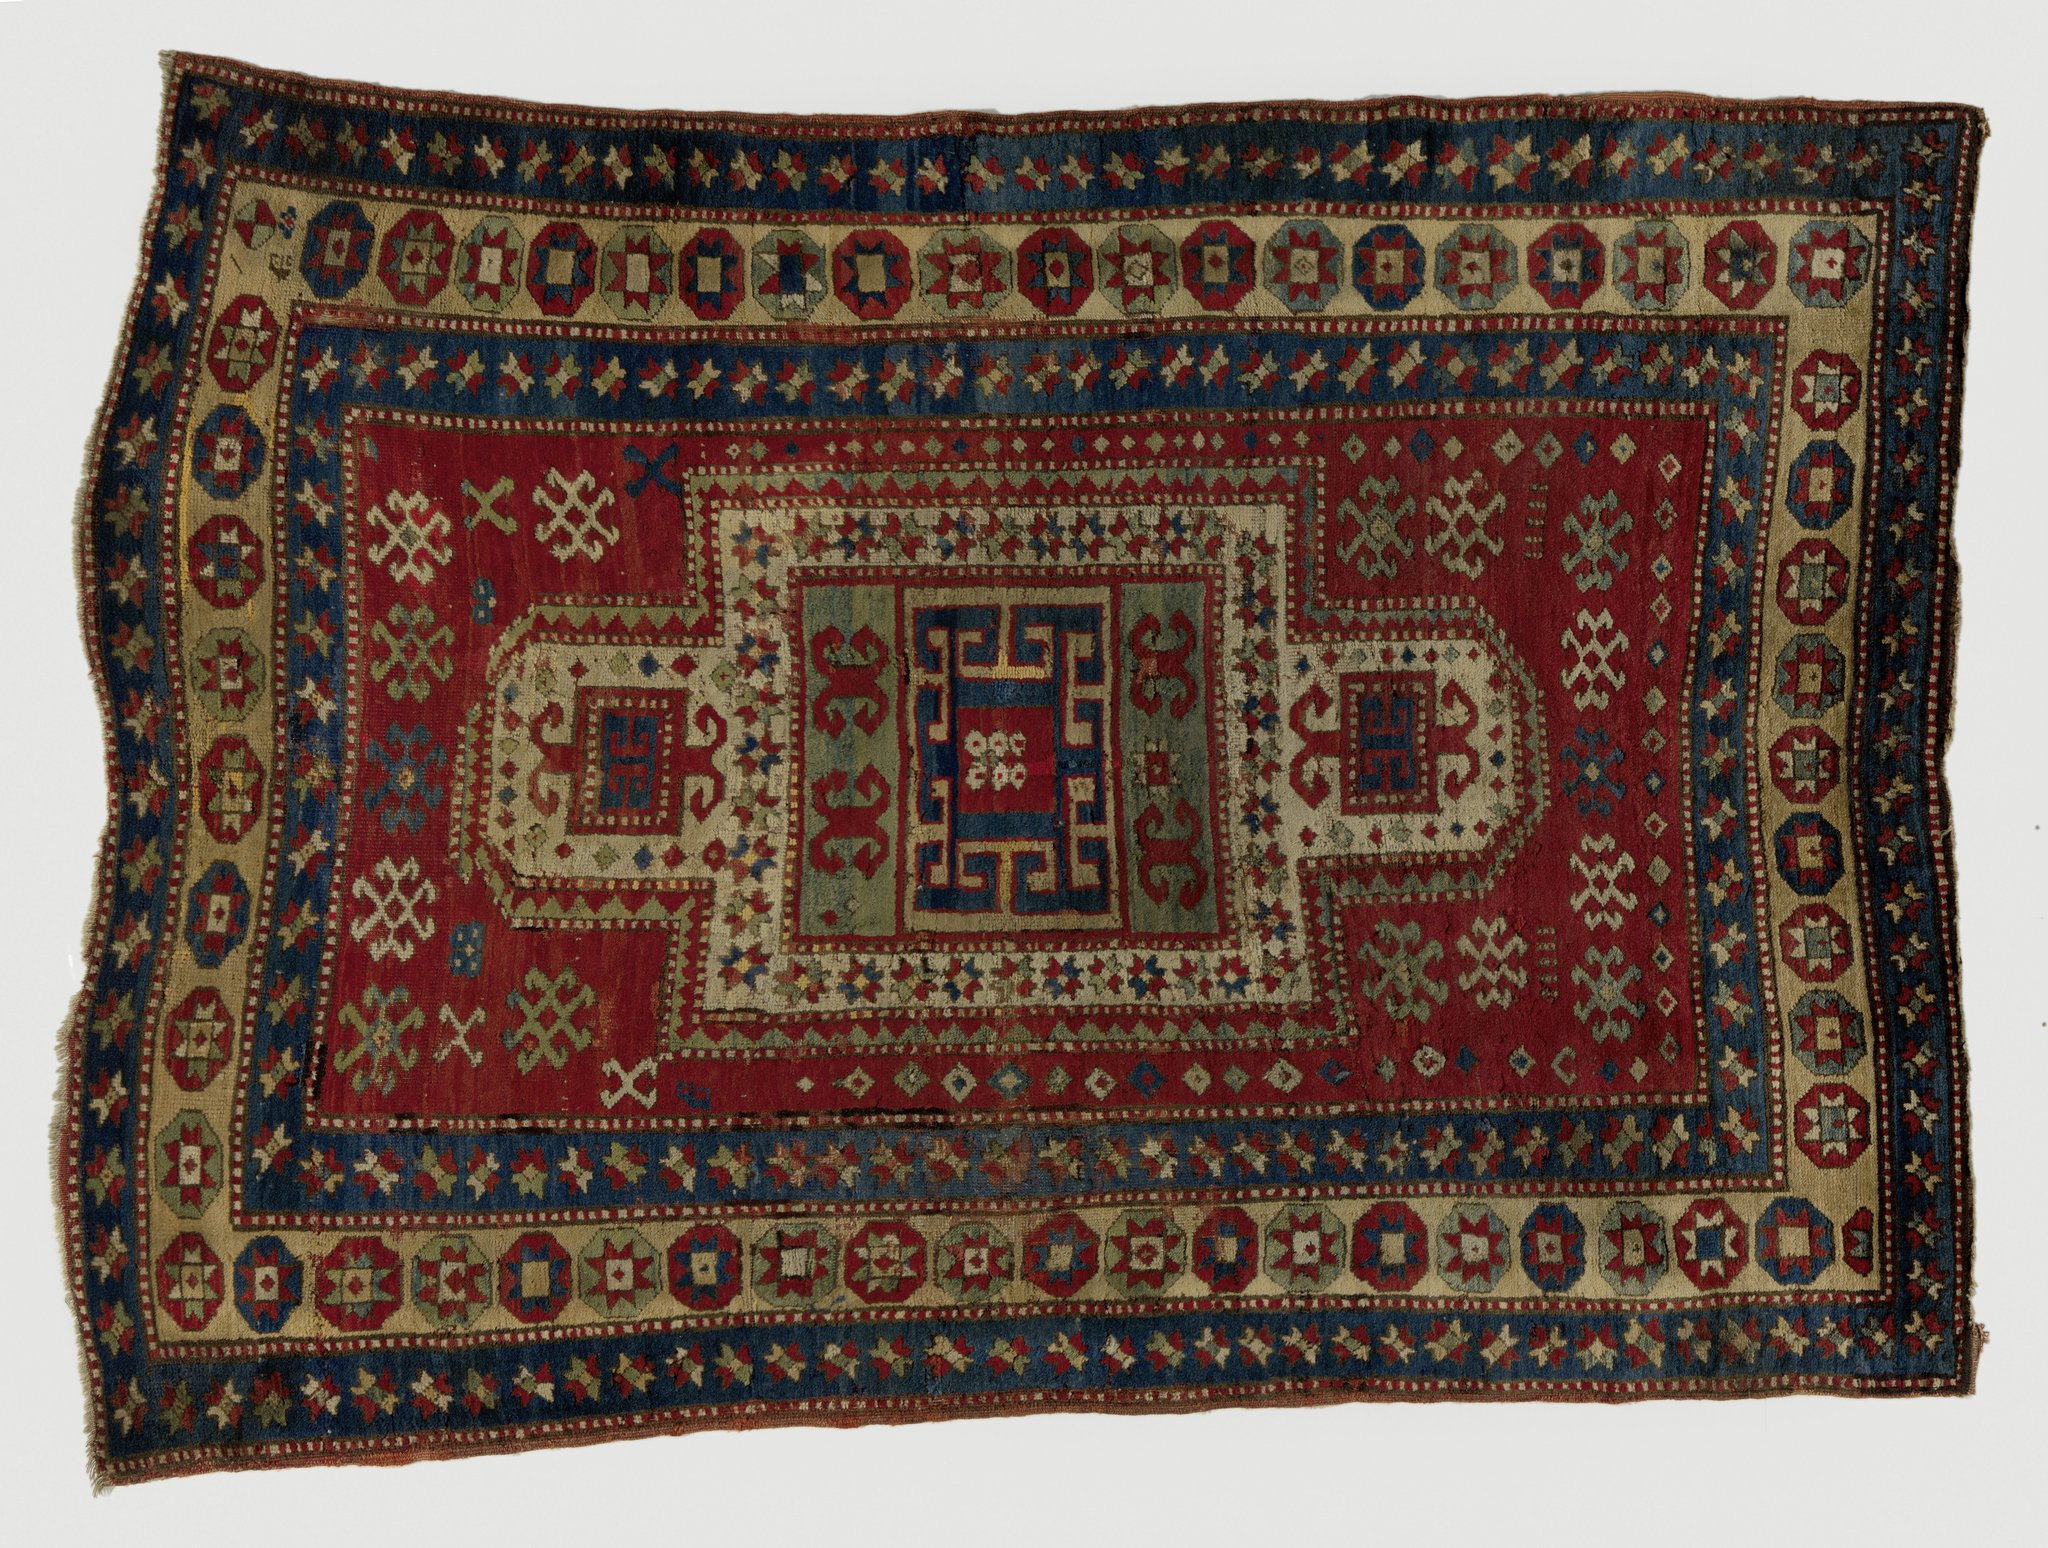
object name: oriental rug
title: Medaillonkleed, KAZAK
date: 1800-1900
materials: wool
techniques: ghiordes knot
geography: kazakhstan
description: Medaillonkleed, Kazak. Middenveld: helderrood fond met een dubbele gele mihrab met witte rand. Binnendecor van zachtgroene panelen, waarop X- en T-haken. Randen: drievoudig; alle even breed. De middelste is goudgeel, waarop achthoeken staan in lichtgroen, rood, ultramarijn en wit, waarbinnen sterren. De binnen- en buitenranden zijn gelijk en vertonen een ultramarijnblauw fond.